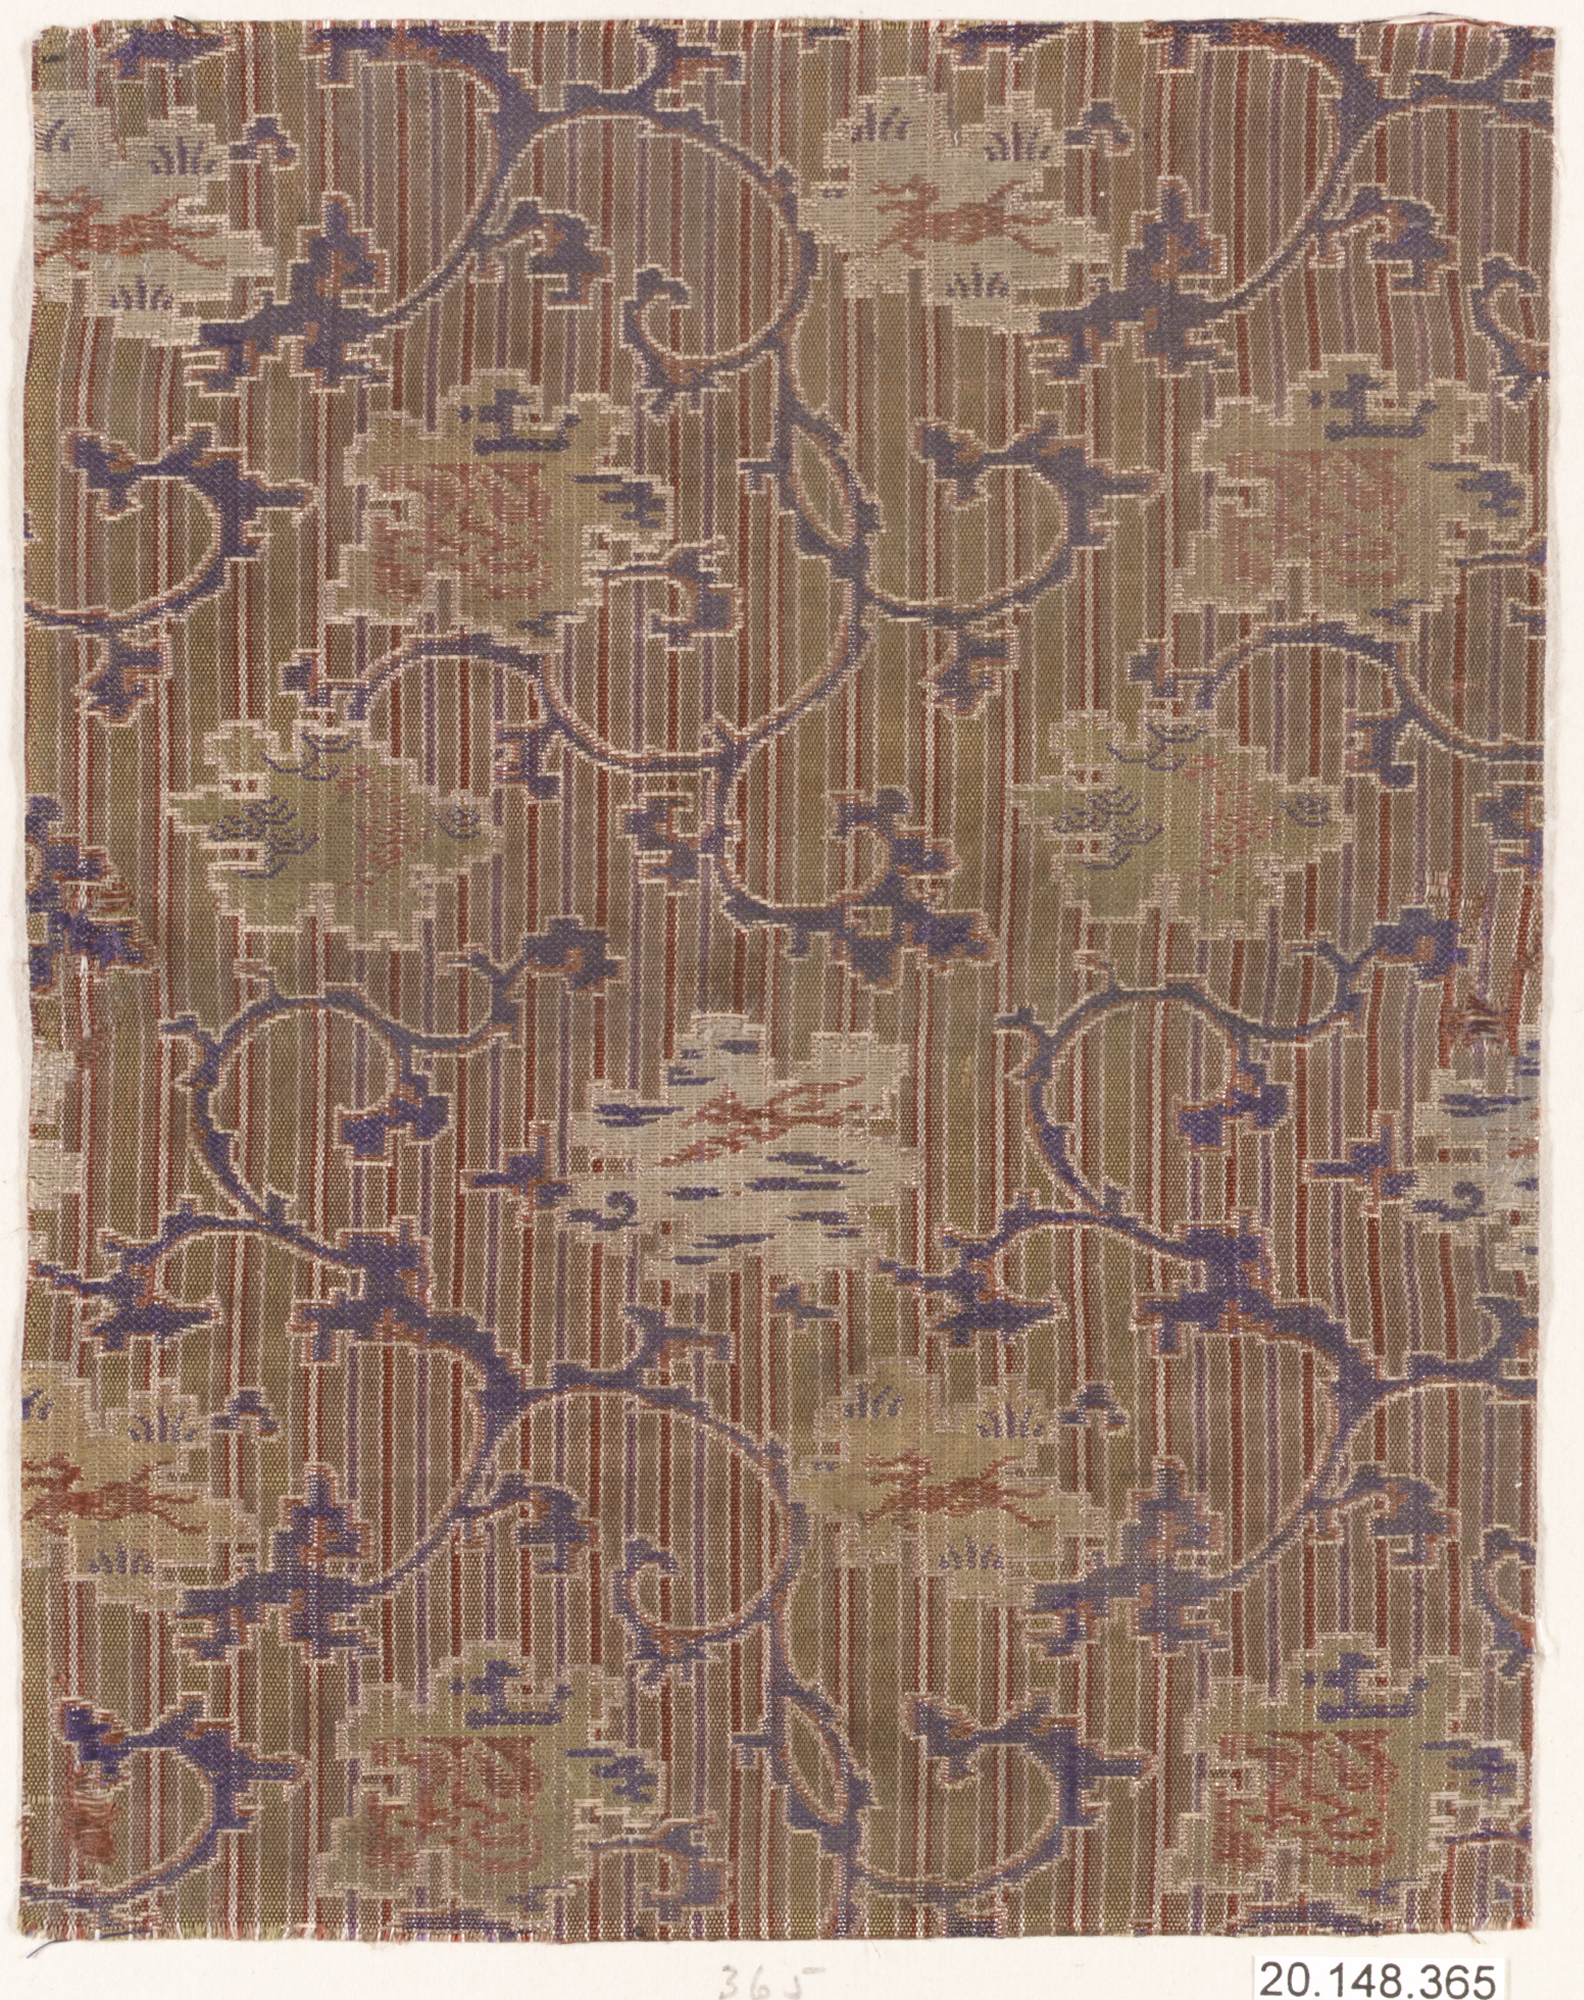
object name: piece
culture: japanese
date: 1701-1800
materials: silk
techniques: compound weave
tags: flowers